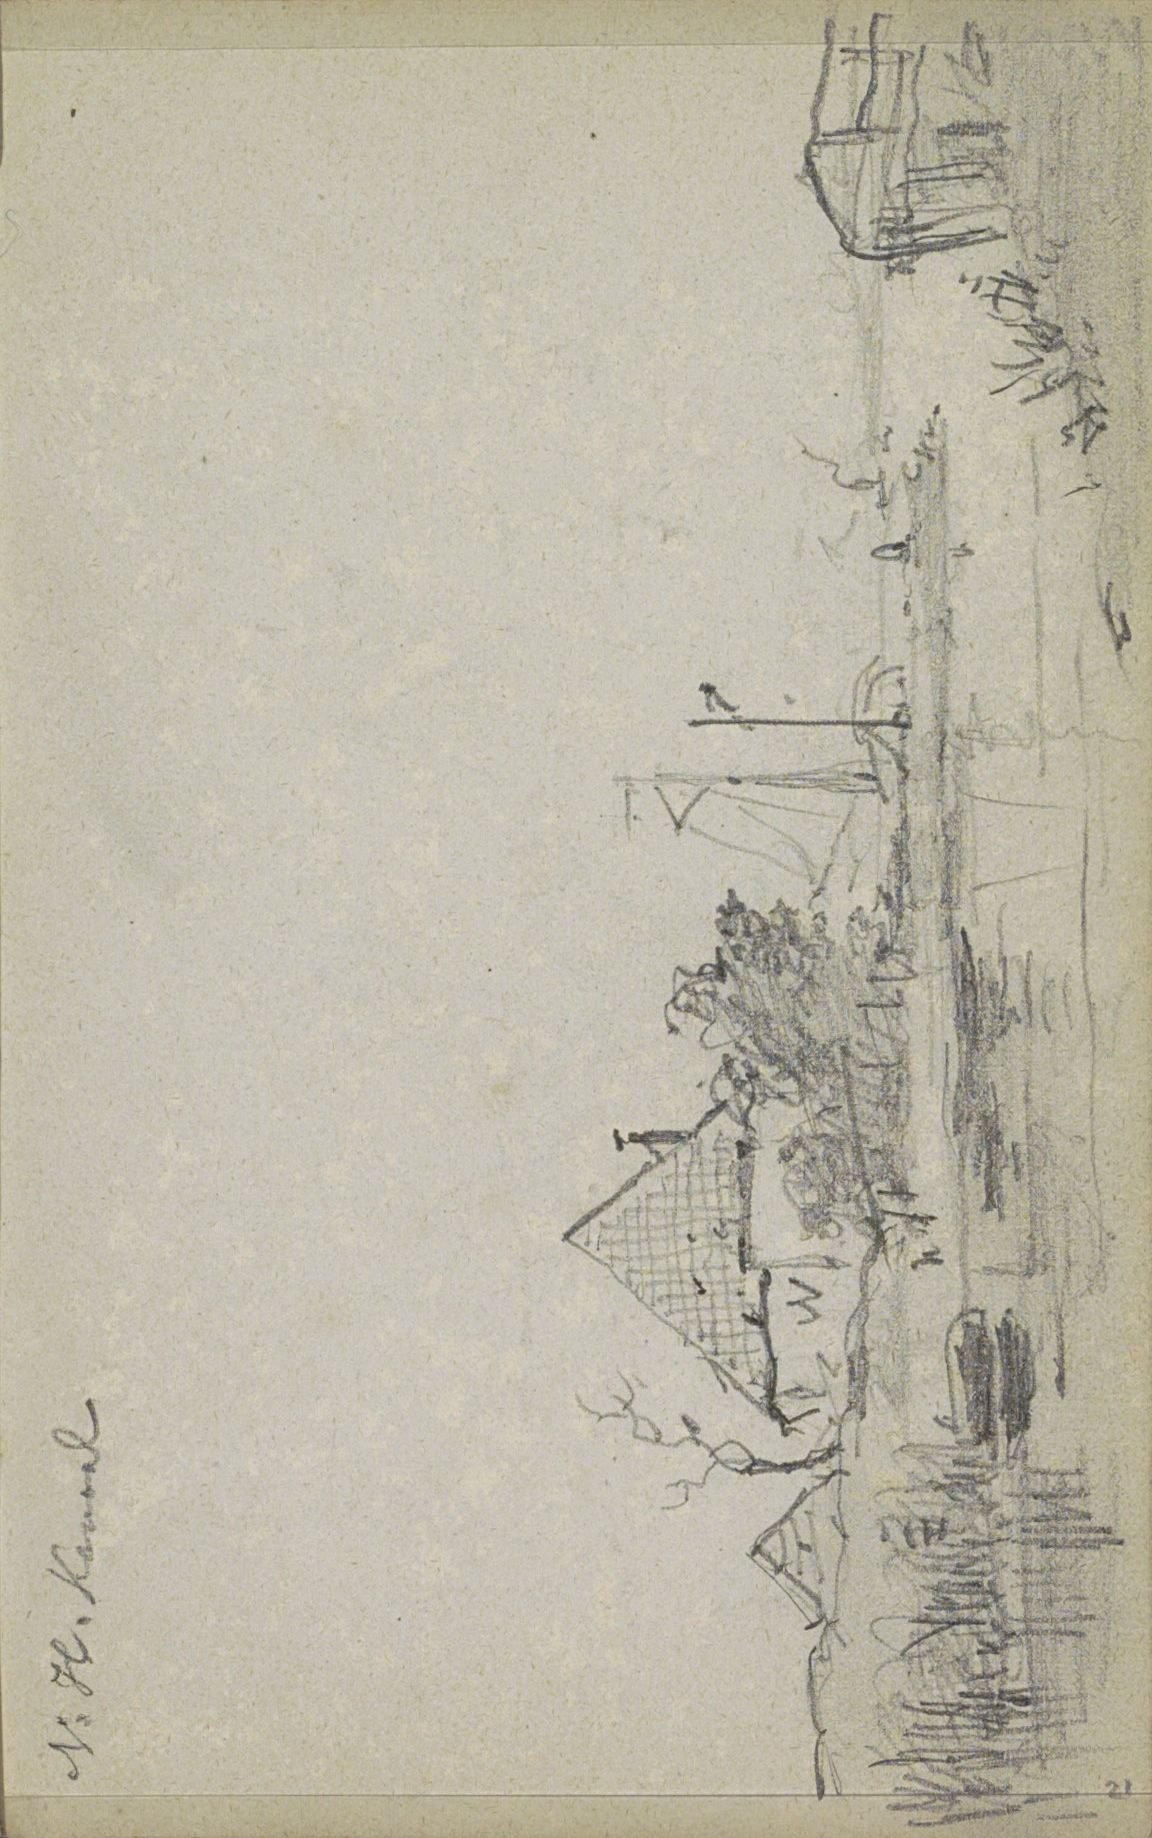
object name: sketchbook leaf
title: Gezicht op het Noordhollandsch Kanaal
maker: adrianus eversen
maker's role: draughtsman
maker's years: 1818-1897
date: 1828-1897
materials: paper, pencil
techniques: stumping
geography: netherlands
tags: sailing-ship, sailing-boat, canal, rowing-boat, canoe, etc.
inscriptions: annotation: ‘N.H. Kanaal’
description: Gezicht op het Noordhollandsch Kanaal. Links een gebouw. In de verte zeilschepen. Linksvoor een boot in het riet. Blad 21 recto uit een schetsboek met 58 bladen.